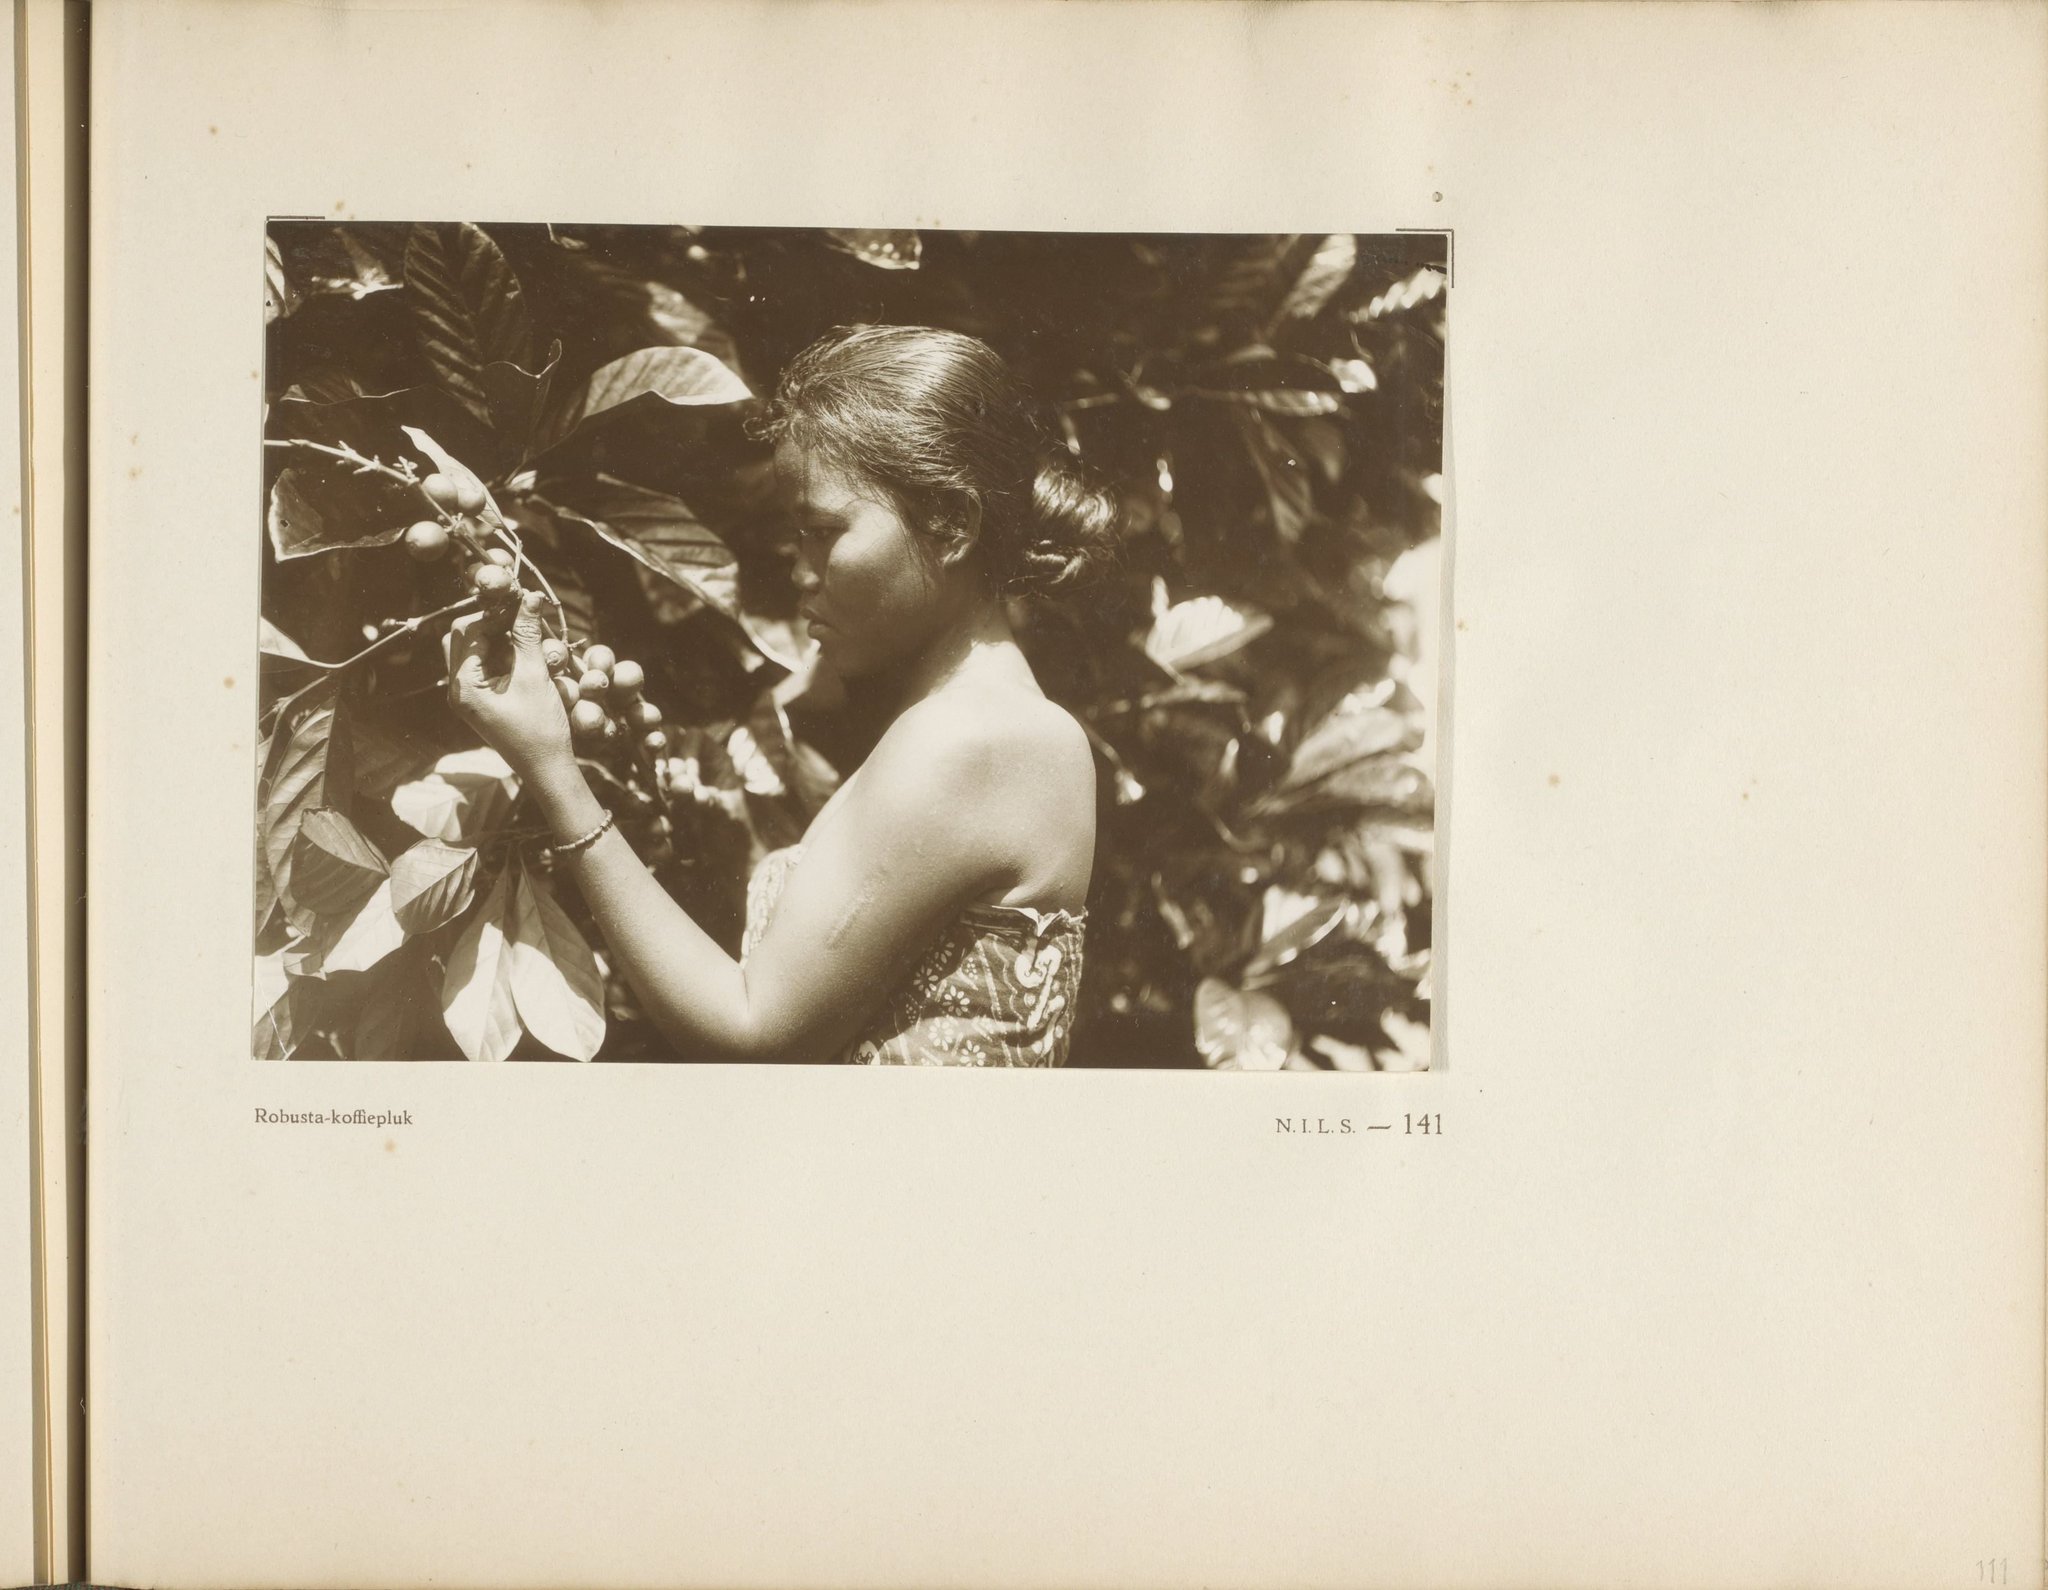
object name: photograph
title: Pagina 141 van fotoboek van de Algemeene Vereeniging van Rubberplanters ter Oostkust van Sumatra (A.V.R.O.S.)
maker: j.w. meyster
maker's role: fotograaf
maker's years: 1887-1945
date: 1924-1925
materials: paper, photographic support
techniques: printing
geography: sumatra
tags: plants; vegetation, coffee, (non-fruit) products of plants or trees: rubber, reaping, picking, mowing ~ harvest, working class, labourers - aa - women, sumatra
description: Boekpagina met een foto van een Indische koffieplukster op Sumatra (koffiesoort: Robusta; Nederlandsch-Indisch Land Syndicaat). Onderdeel van een fotoboek van de Algemeene Vereeniging van Rubberplanters ter Oostkust van Sumatra (A.V.R.O.S.).